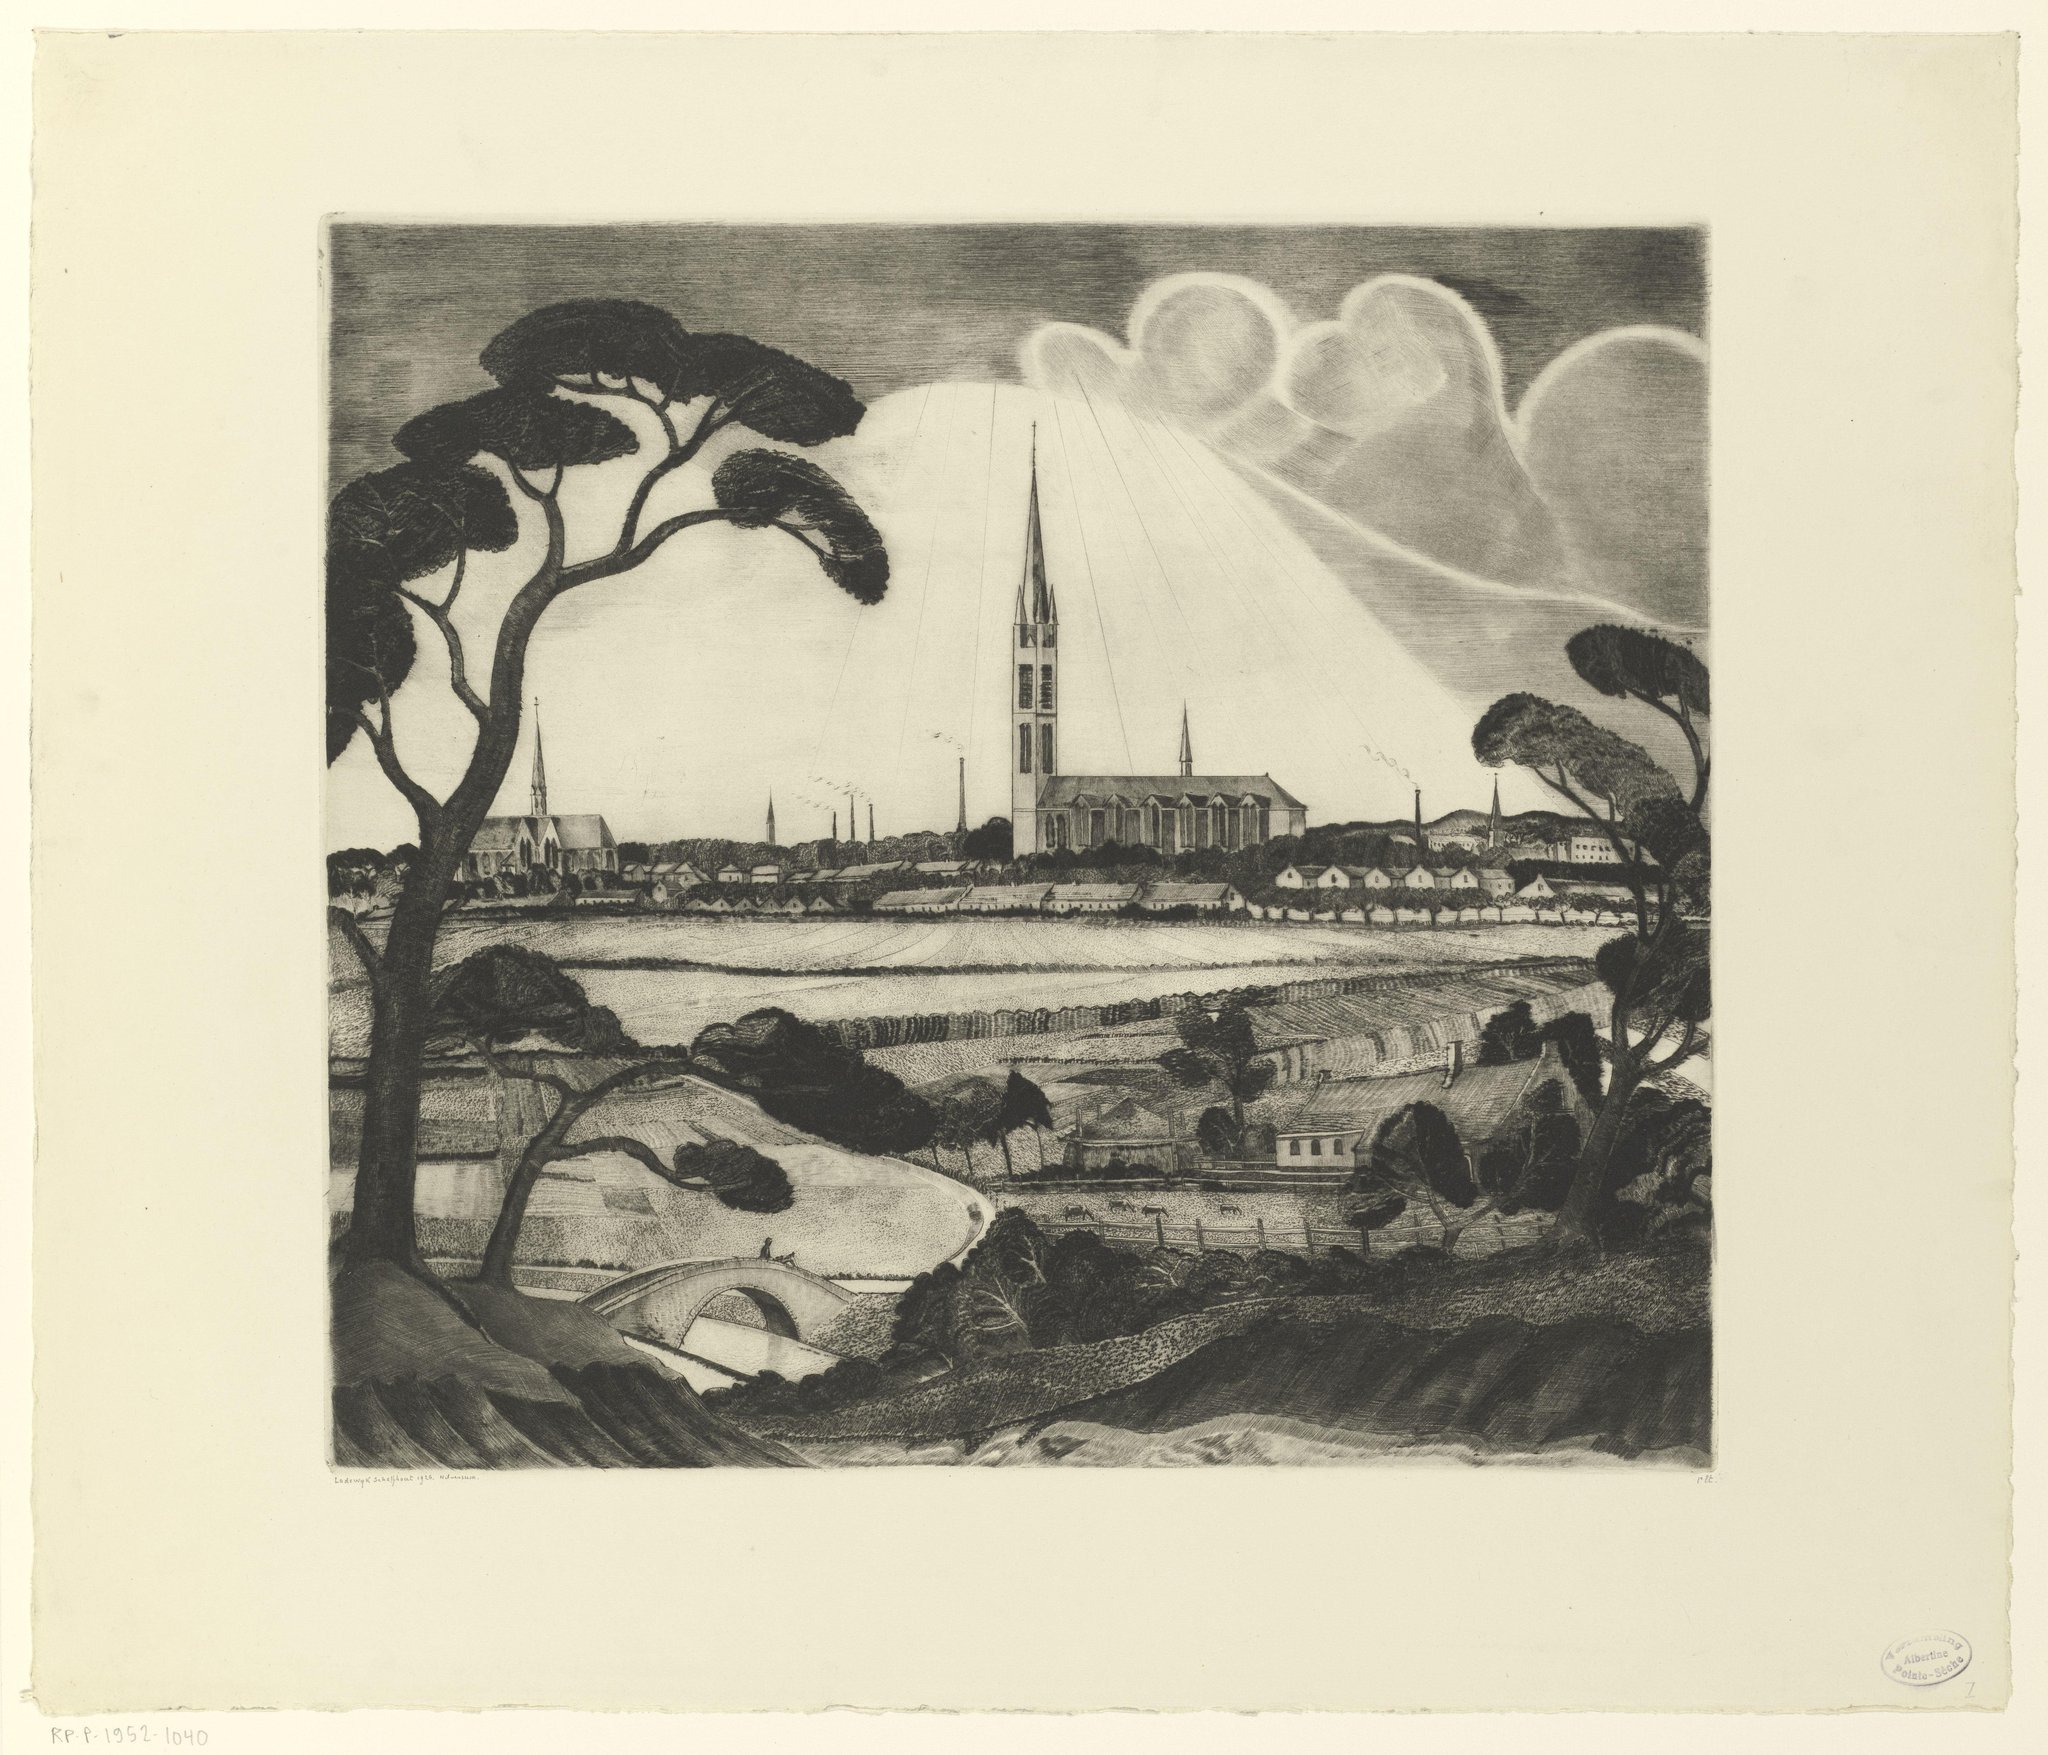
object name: print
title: Hilversum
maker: lodewijk schelfhout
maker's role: draughtsman, print maker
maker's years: 1881-1943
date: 1926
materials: paper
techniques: drypoint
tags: city-view, and landscape with man-made constructions, church (exterior), farm (building)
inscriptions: collector's mark: Lugt 5i, collector's mark: Lugt 2228, collector's mark: Lugt 2760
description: Op de voorgrond een brug over een stroom en een boerderij met hooiberg. Links op de achtergrond de Onze Lieve Vrouwe Kerk Onbevlekt Ontvangen. In het midden op de achtergrond de Sint Vituskerk.